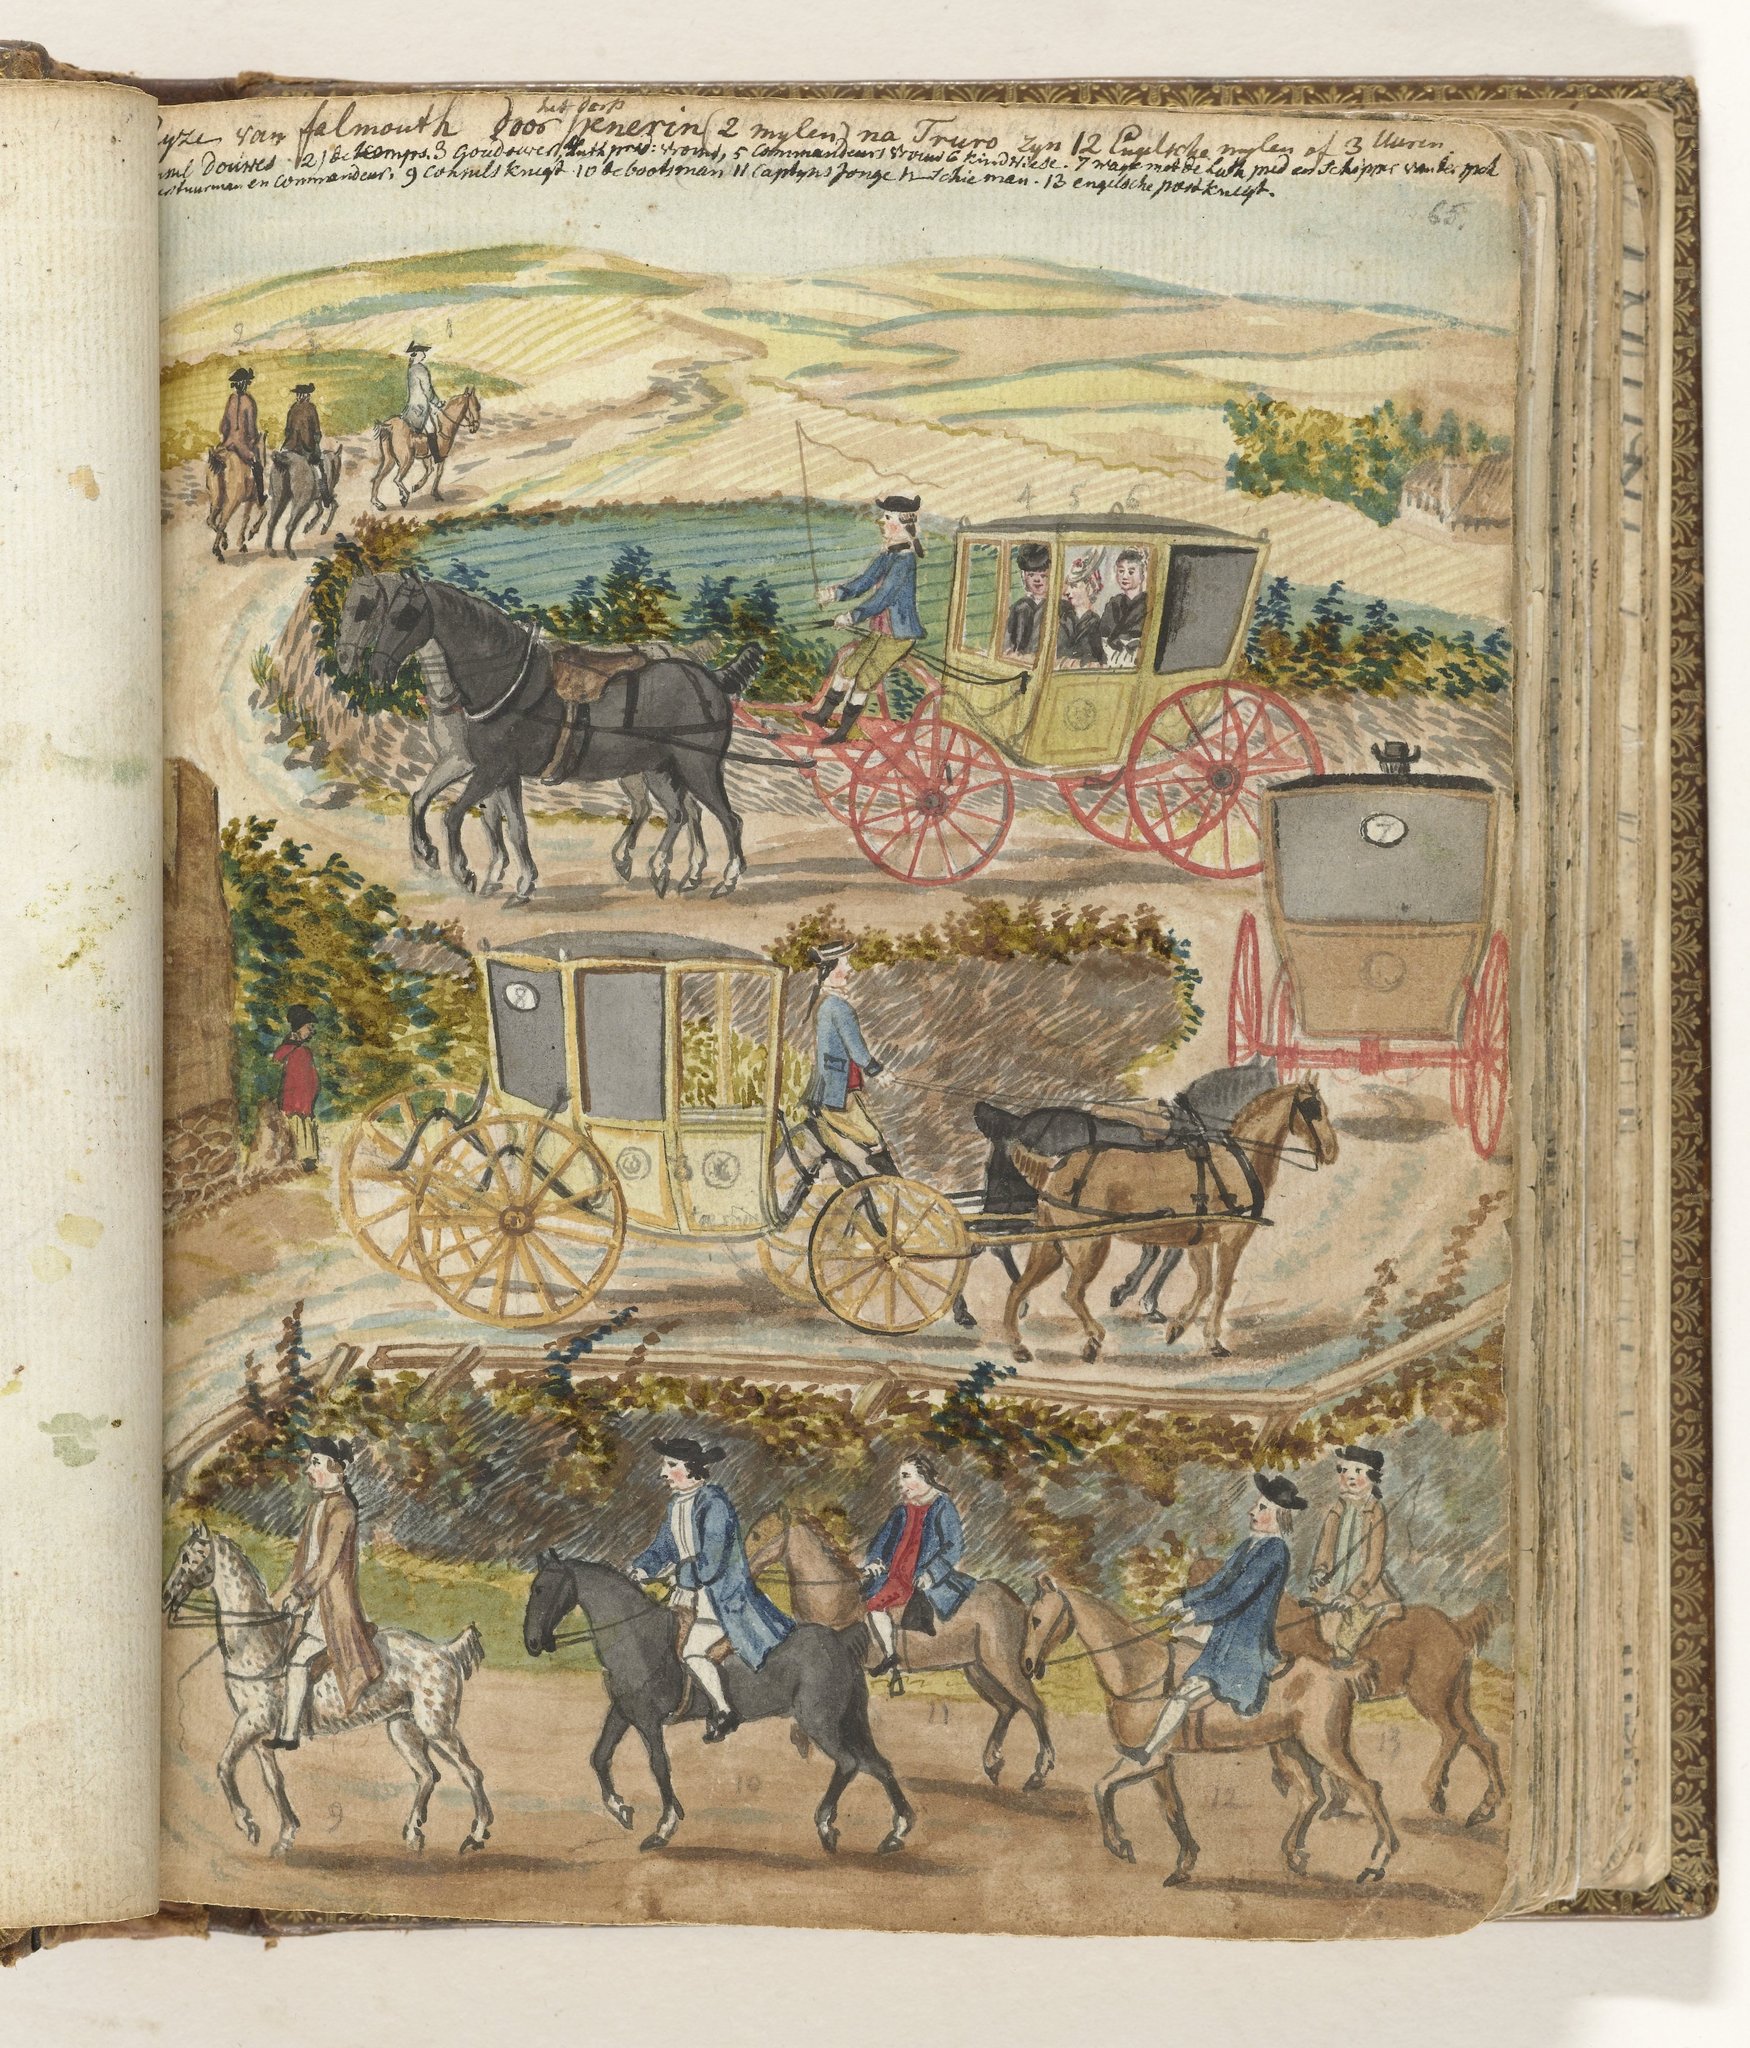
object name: drawing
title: Reis van Falmouth naar Truro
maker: jan brandes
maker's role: draughtsman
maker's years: 1743-1808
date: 1706-1778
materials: paper, pencil, watercolor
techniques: brush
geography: penryn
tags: four-wheeled vehicle drawn by two animals, 'en route', traveller under way, england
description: Kleurtekening van ruiters en koetsen die een steile (kust)weg omhoog rijden in glooiend Zuid-Engels landschap. Met opschrift. Onderdeel uit het schetsboek van Jan Brandes, dl. 2 (1808), p. 65 en zie deel 2, p. 81-82.